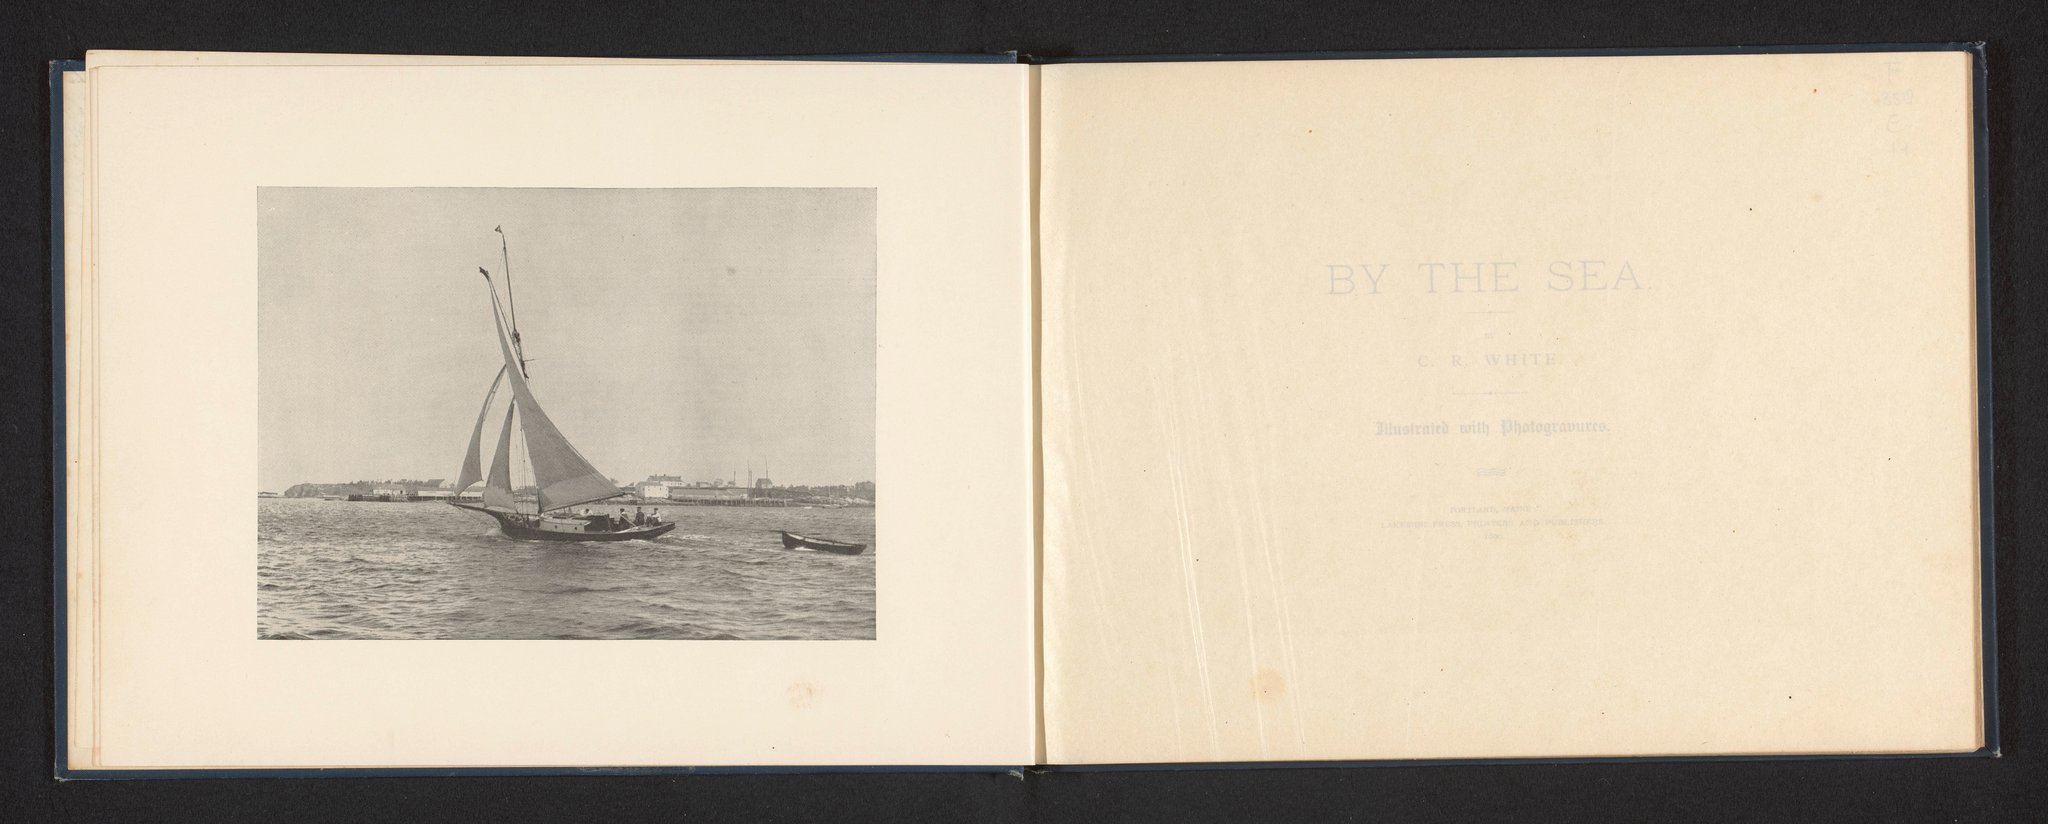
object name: page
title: Gezicht op een zeilboot voor de kust van Maine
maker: Anonymous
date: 1880-1890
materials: paper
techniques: photoaquatint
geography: maine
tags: sailing-ship, sailing-boat, coast